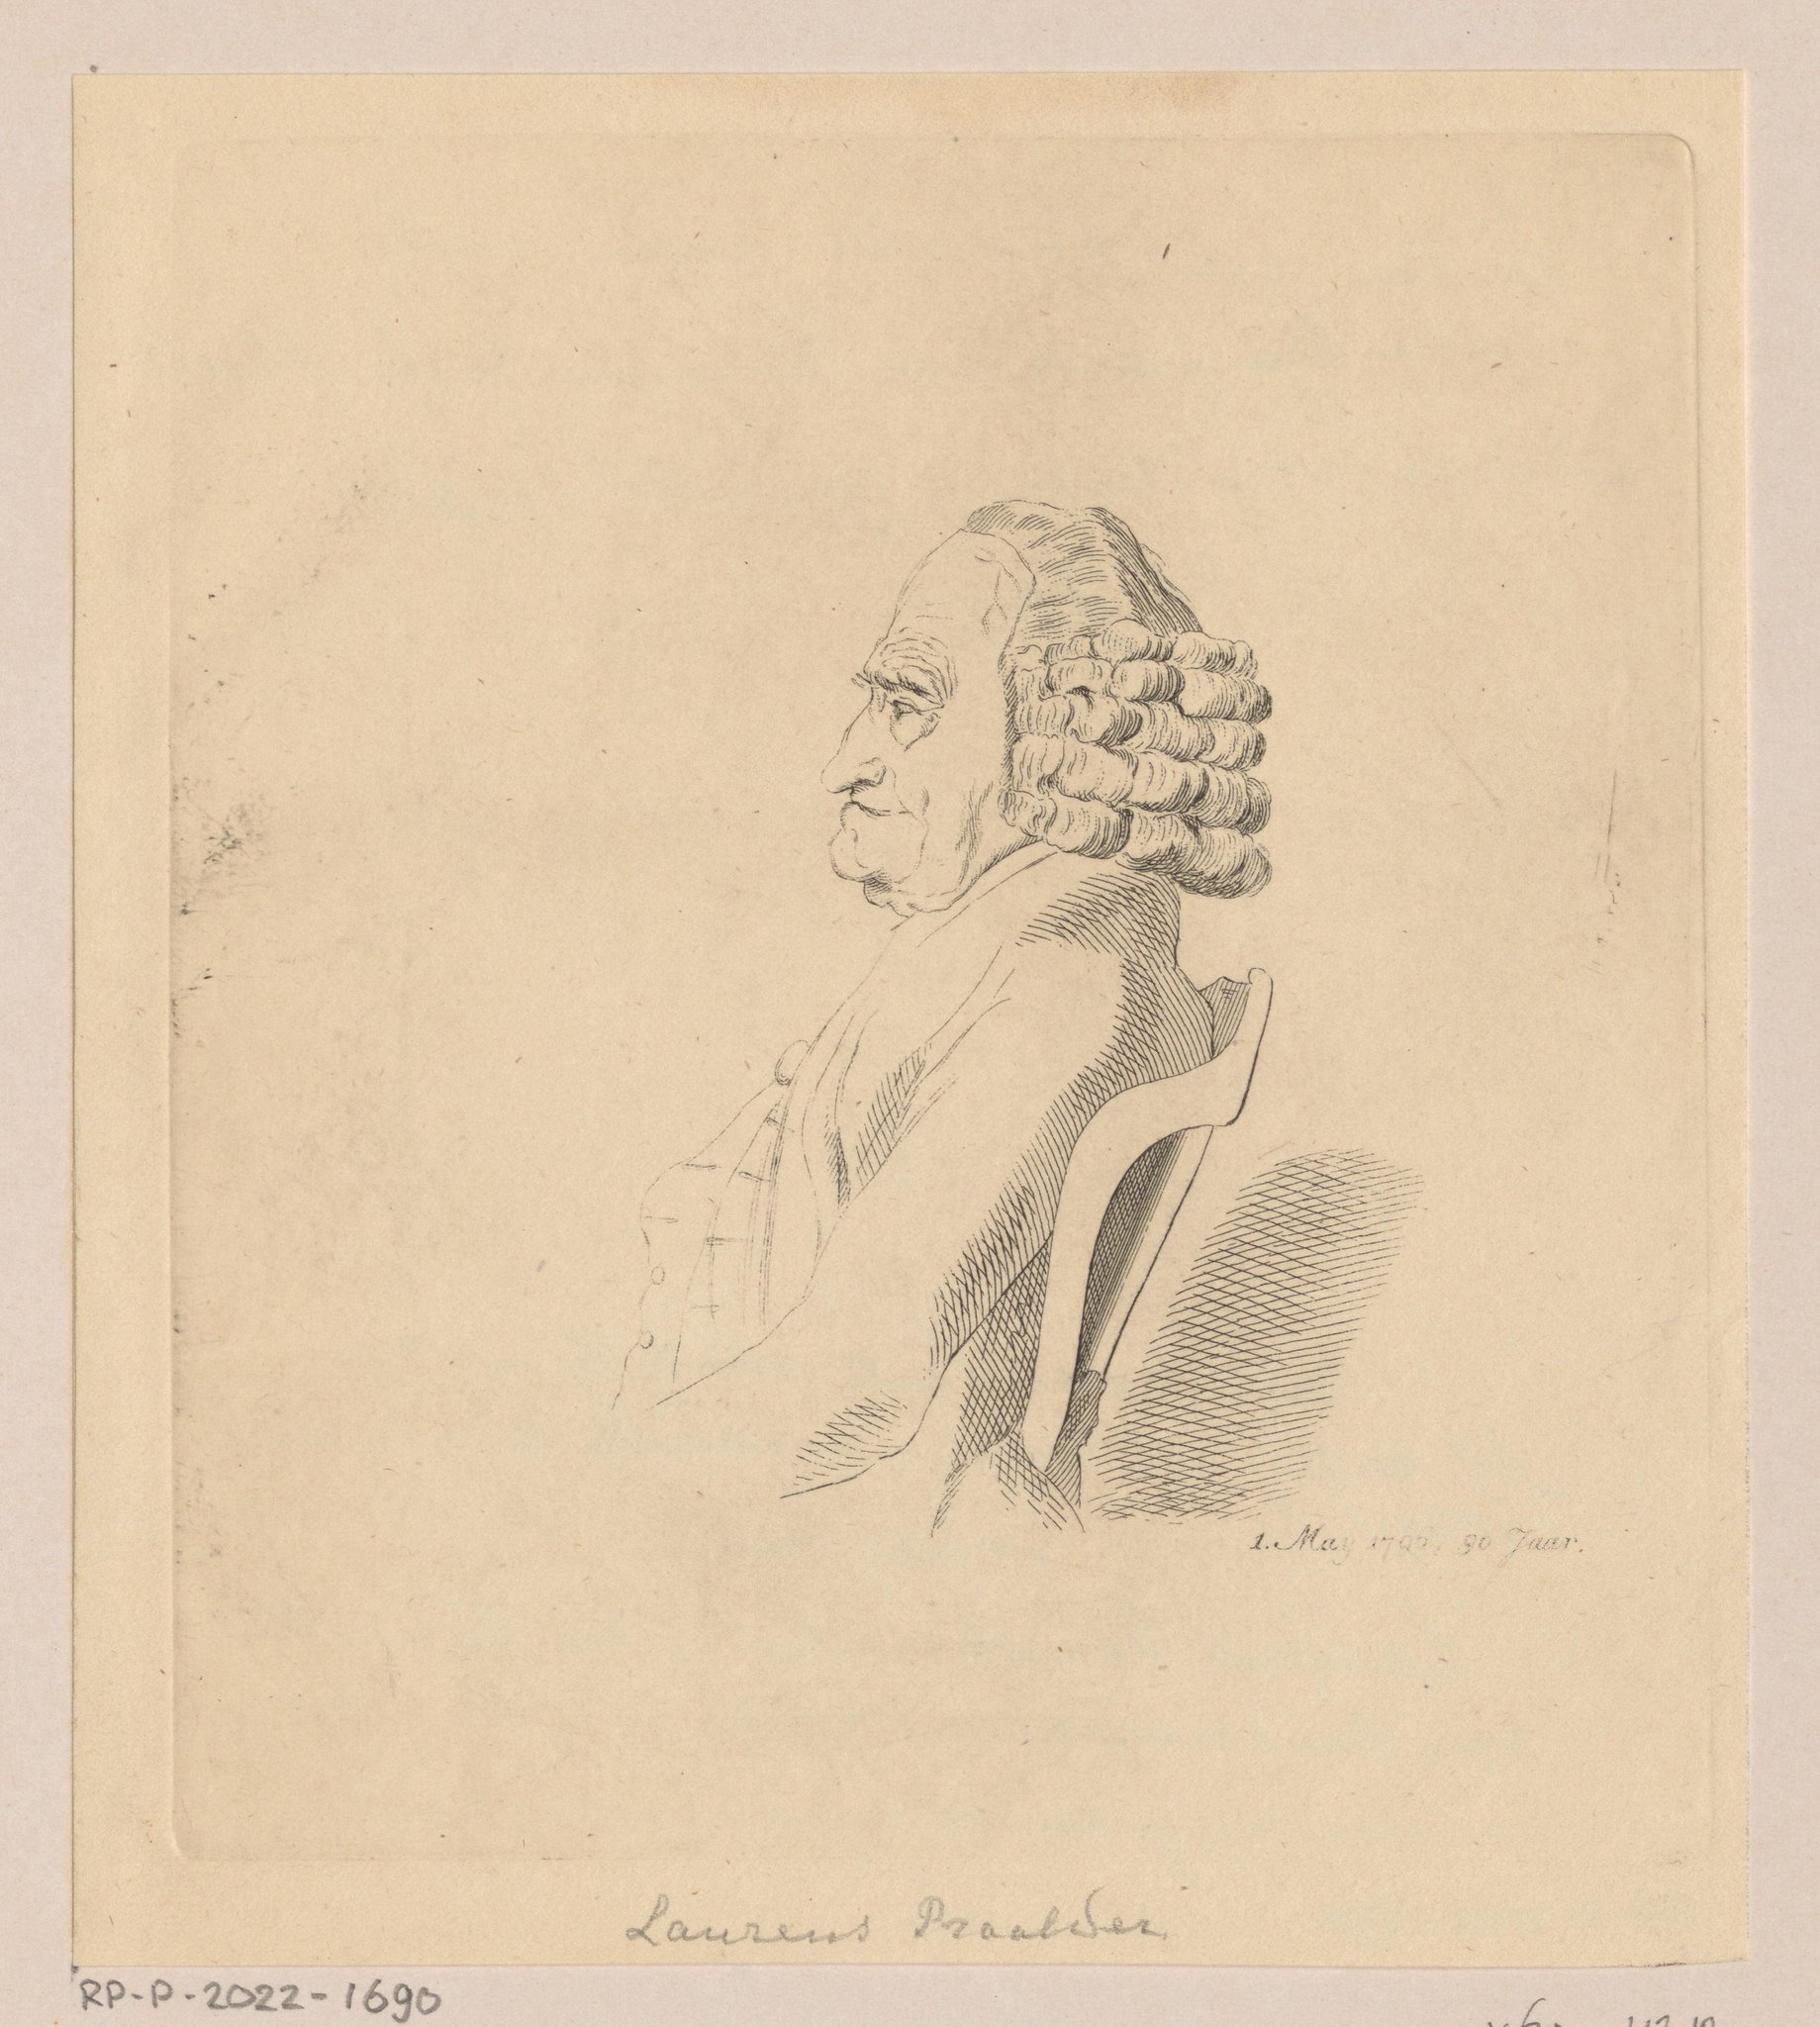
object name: print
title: Portret van Laurens Praalder op 90-jarige leeftijd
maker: Anonymous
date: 1796-1825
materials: paper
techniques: etching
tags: schagen, historical persons, wig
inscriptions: inscription: ‘Lector der Fundatie (...) genootschappen / 96 jaar’, inscription: ‘Deze Koperplaat berust (...) -scheidene geleerde genootschappen’